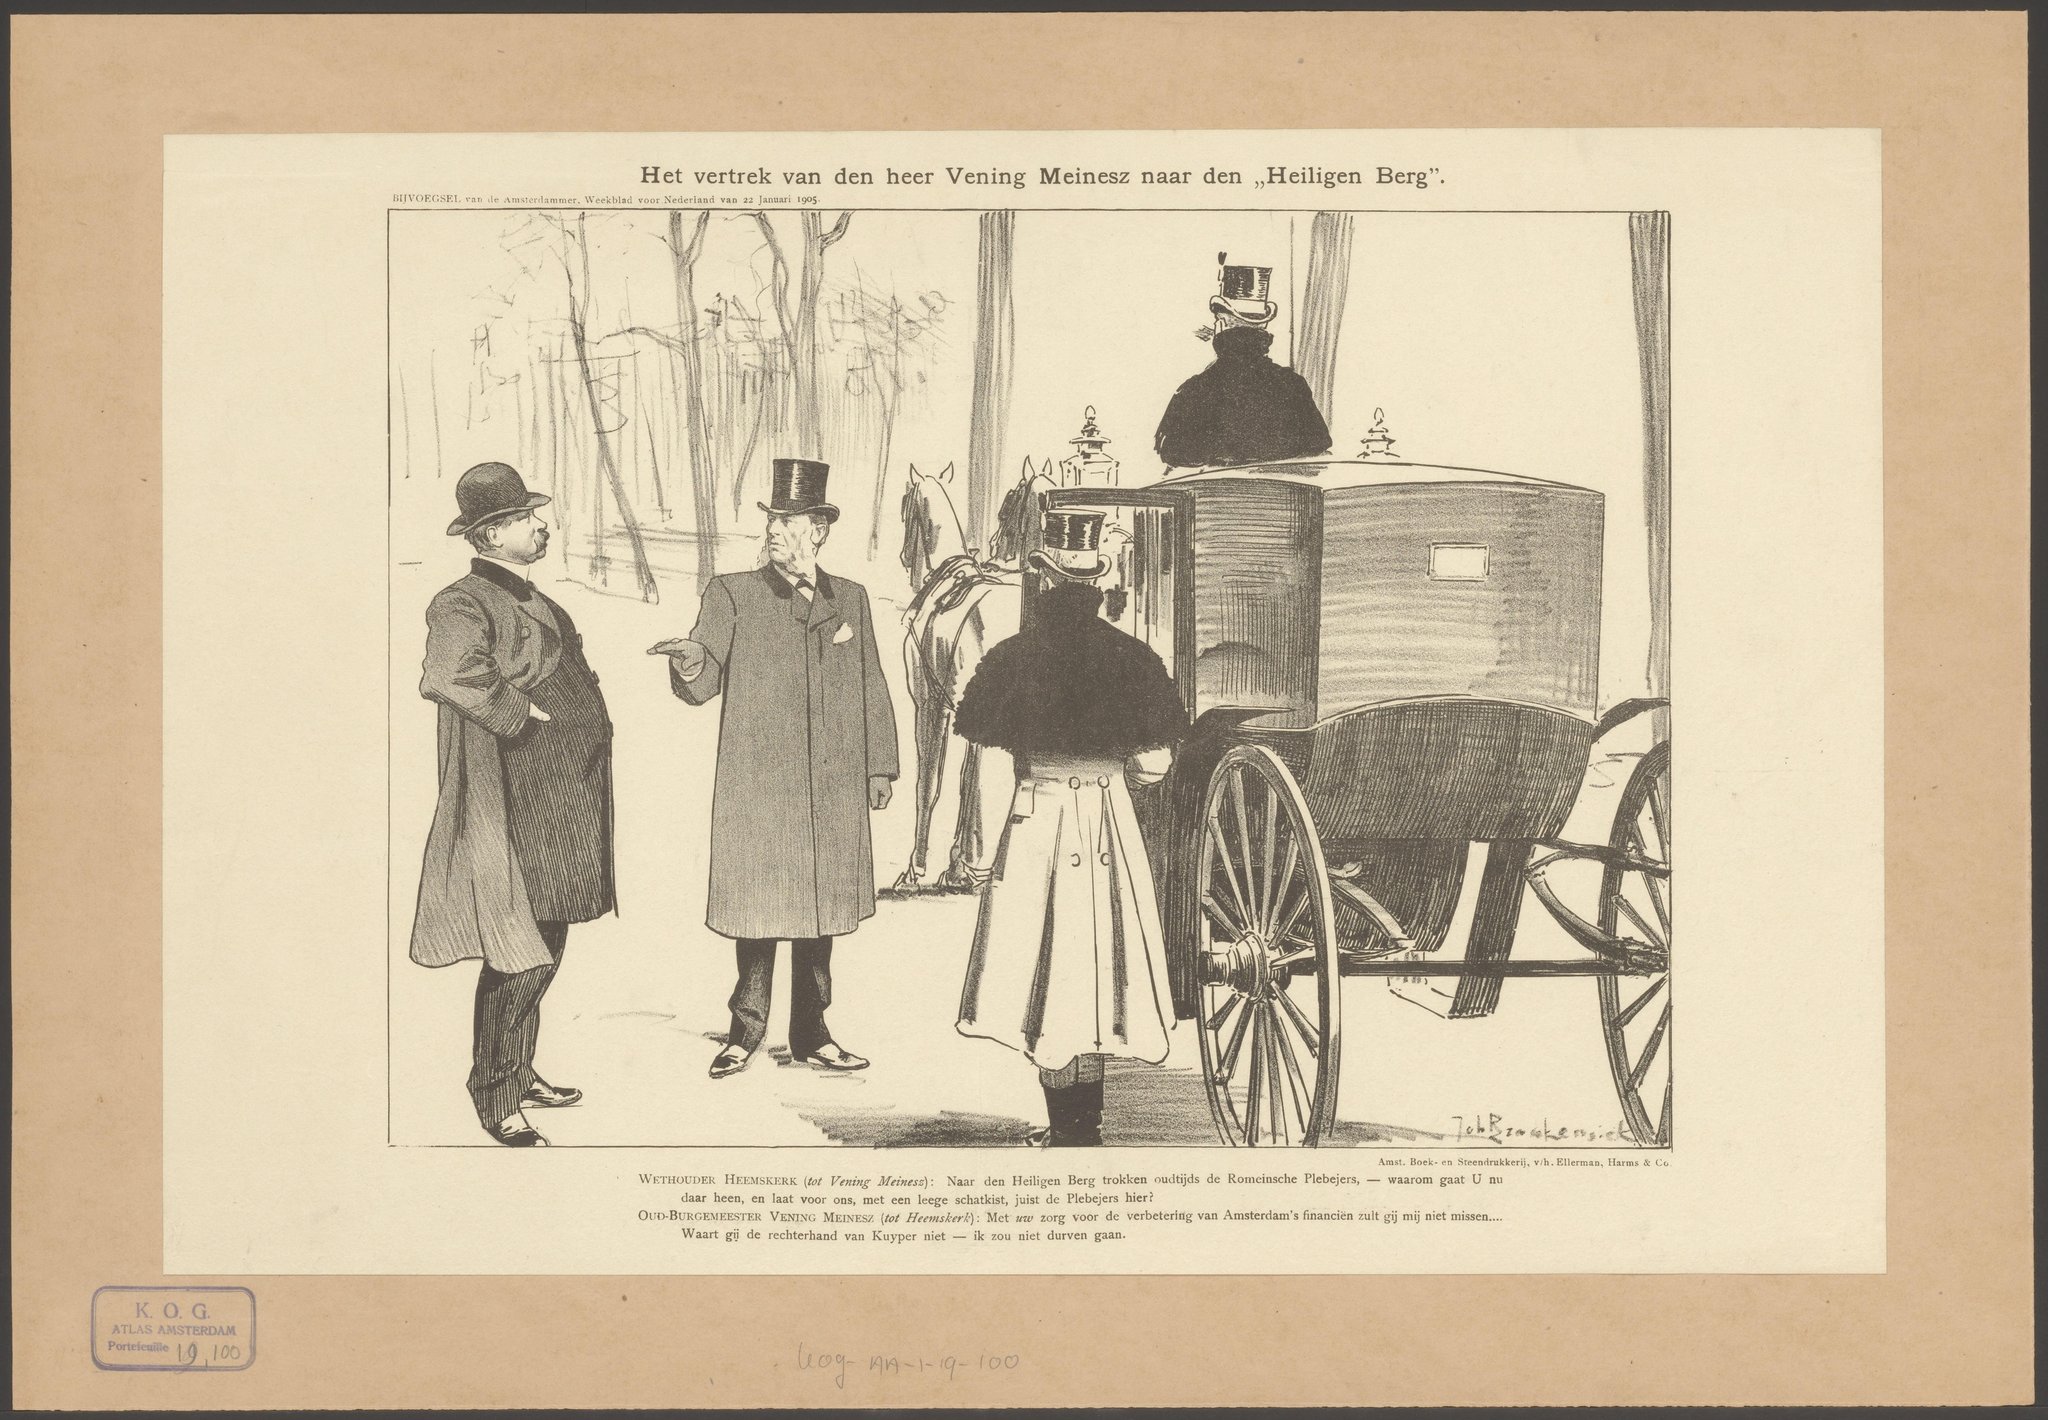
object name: cartoon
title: Het vertrek van den heer Vening Meinesz naar den "Heiligen Berg"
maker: johan braakensiek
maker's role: draughtsman, print maker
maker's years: 1858-1940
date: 1905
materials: paper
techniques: letterpress printing, lithograph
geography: amsterdam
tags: harlingen, politician, politician, e.g. party leader, political caricatures and satires, amsterdam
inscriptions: collector's mark: ‘19,100’ Lugt 1641b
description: Onderwerpsrubriek binnen de Atlas Amsterdam: Herinneringen aan regeringsleden en hunne huisgezinnen [na 1800].